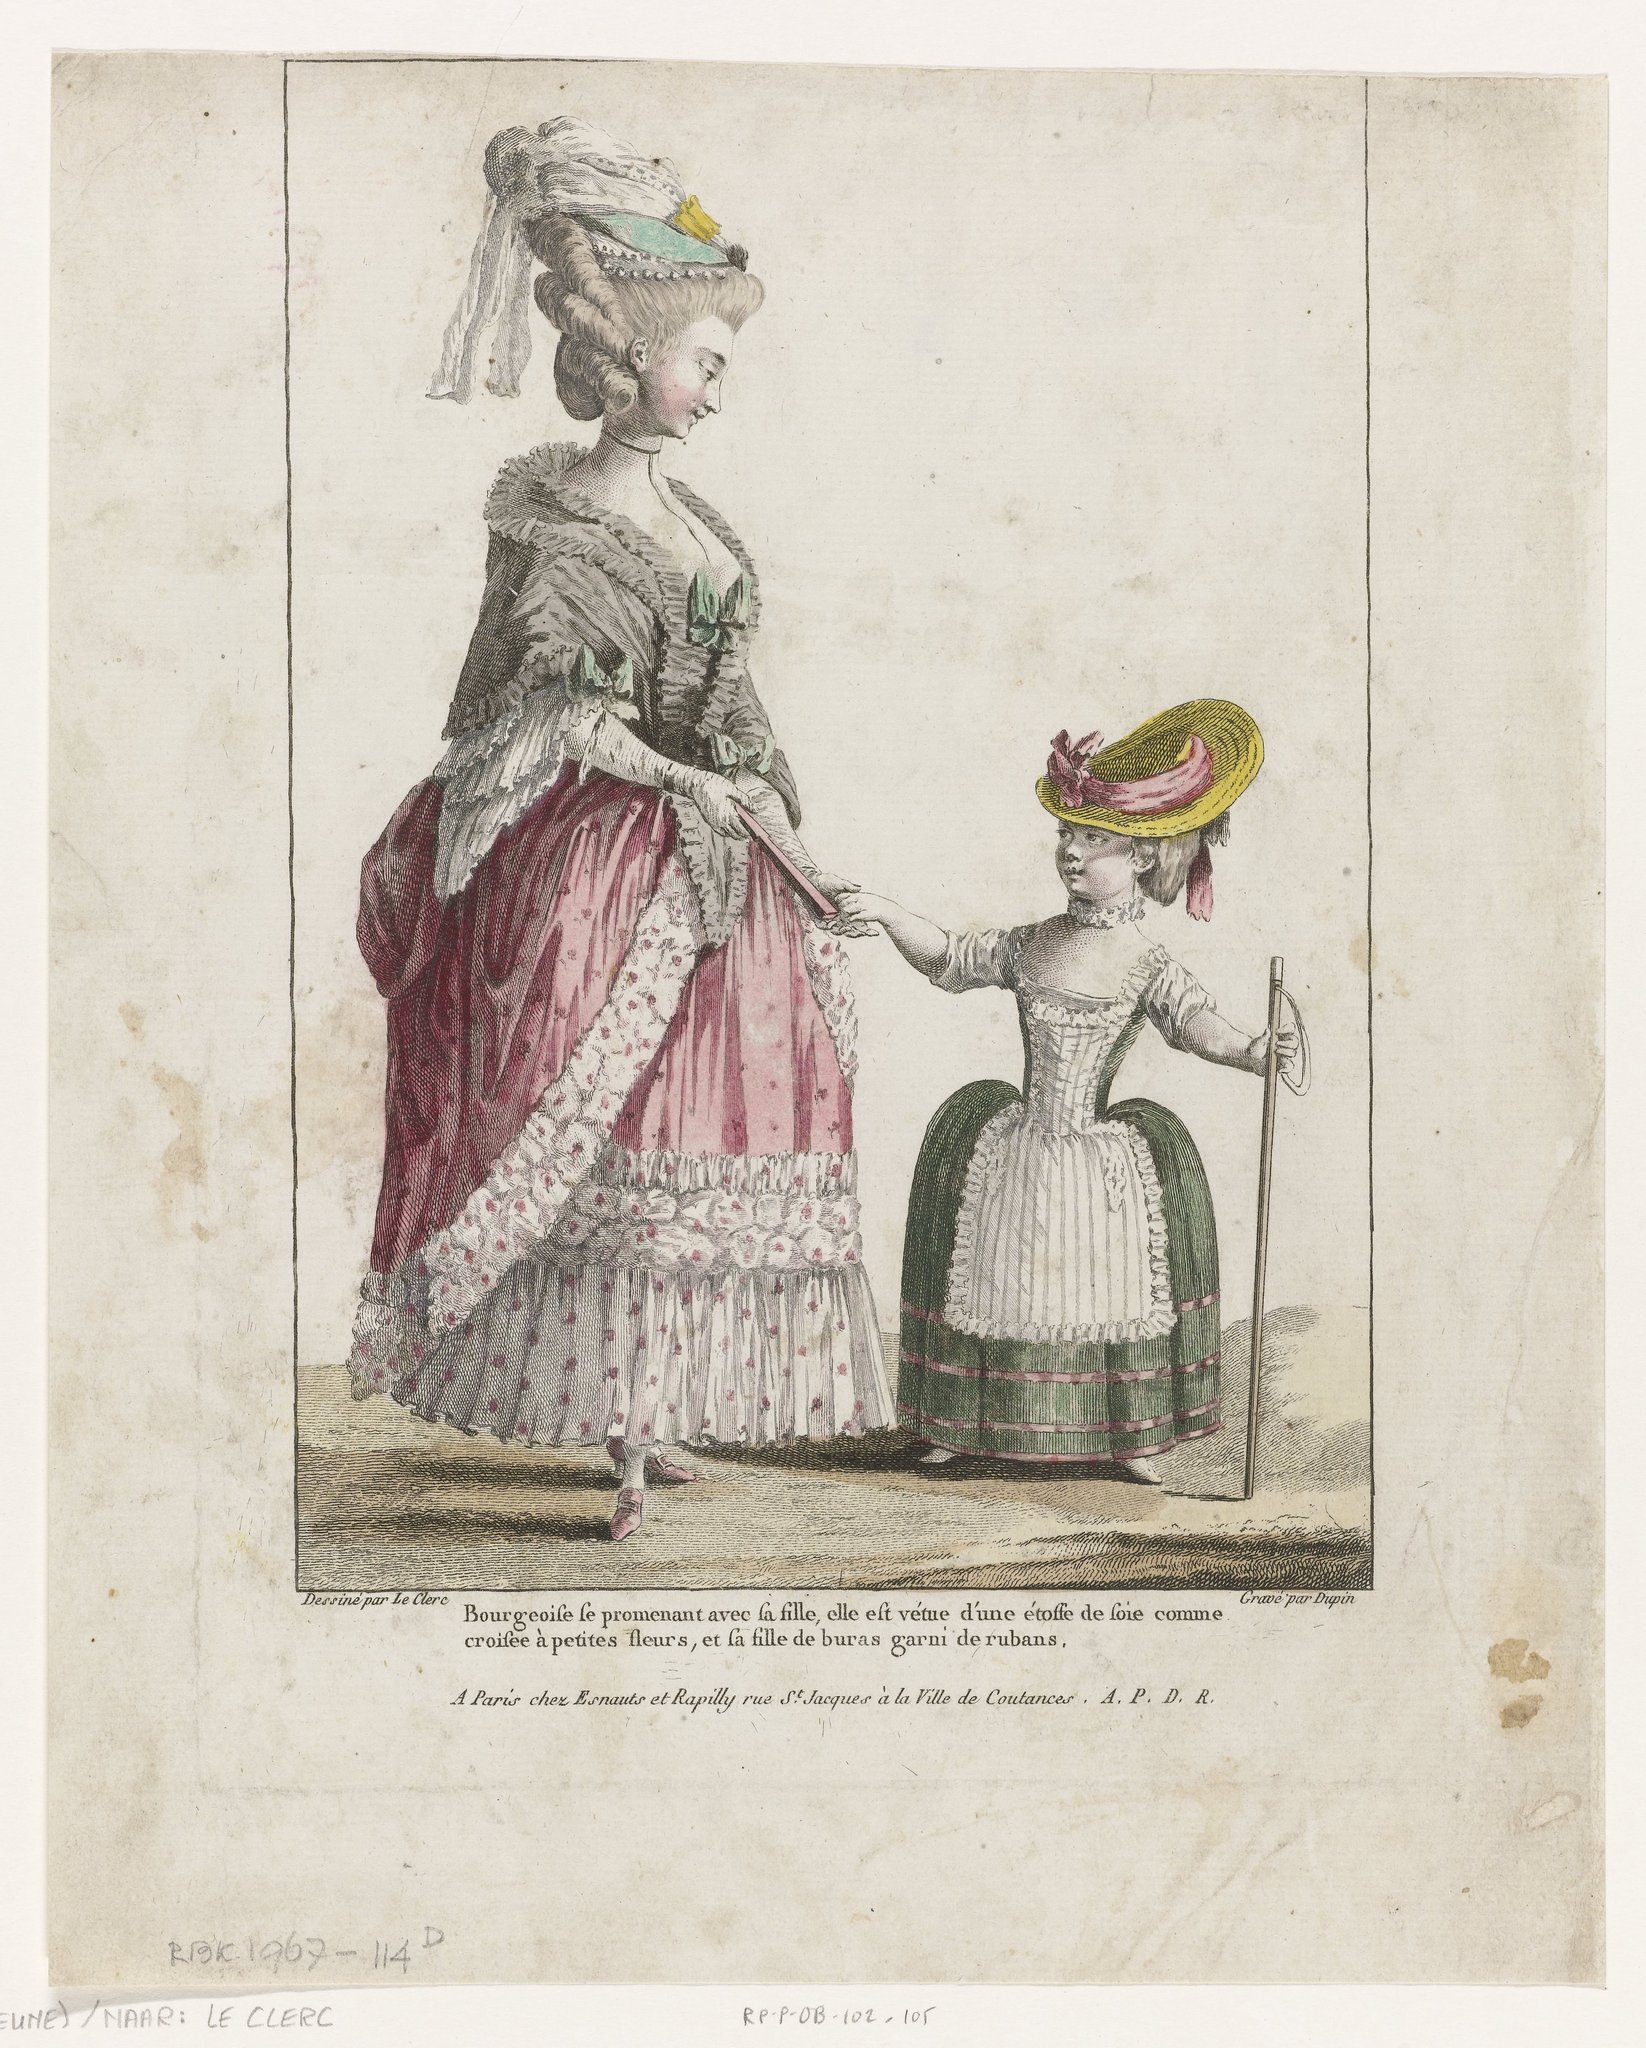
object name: fashion print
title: Gallerie des Modes et Costumes Francais 1780, H. 43: Bourgeoise se promenant (...).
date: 1778-1782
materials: paper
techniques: etching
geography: paris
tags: clothes, costume (+ girls' clothes), walking-stick, staff, cane (+ girls' clothes), neck-gear ~ clothing (ruff) (+ girls' clothes), apron (+ girls' clothes), head-gear: hat (+ girls' clothes), clothing for the upper part of the body (mantelet) (+ women's clothes), styles of hairdress - aa - ~ women, fashion plates, clothes, costume (+ women's clothes), head-gear: hat (+ women's clothes), shoes, sandals (+ women's clothes), gloves, mittens, etc. (+ women's clothes), head-gear: hat (+ other materials used for clothes), dress, gown (+ girls' clothes), dress, gown: robe à la polonaise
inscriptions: caption: ‘Bourgeoise se promenant avec sa fille, elle est vetue d'une étoffe de soie comme croisée a petites fleurs, et sa fille de buras garni de rubans’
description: Burgervrouw, wandelend met haar dochtertje. Vrouw naar rechts, gekleed in een schoudermantel over een 'robe à la Polonaise' met engageantes en falbala's, Ze heeft een gesloten vouwwaaier in de gehandschoende rechterhand. Aan de voeten puntschoenen met hakje en gesp. Naast haar een meisje met een strooien hoedje op, een wandelstokje in de hand. Met onderschrift: Bourgeoise se promenant avec sa fille....